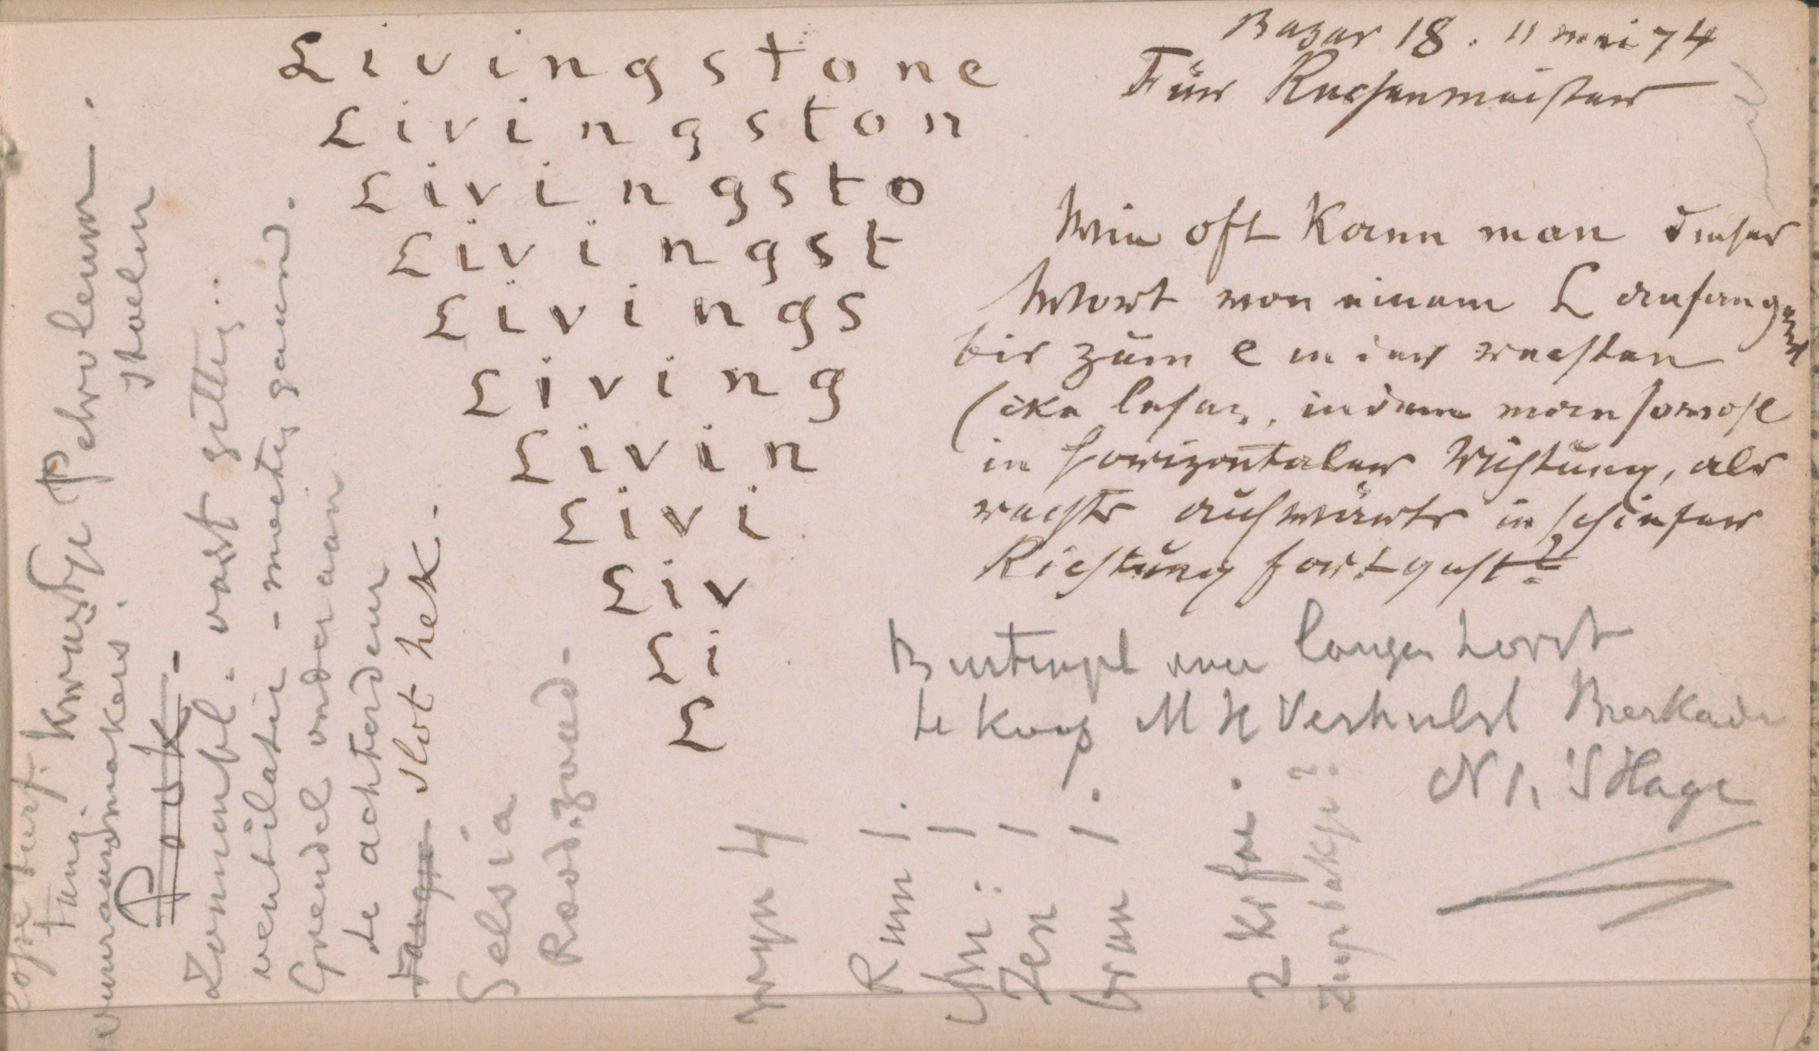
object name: endleaf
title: Notities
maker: johannes tavenraat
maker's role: draughtsman, painter, print maker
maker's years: 1809-1881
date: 1873-1876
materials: ink, paper, pencil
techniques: pen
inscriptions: date and inscription: ‘[...]’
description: Blad 46 recto, achterste vrije schutblad, uit een schetsboek met 46 bladen.